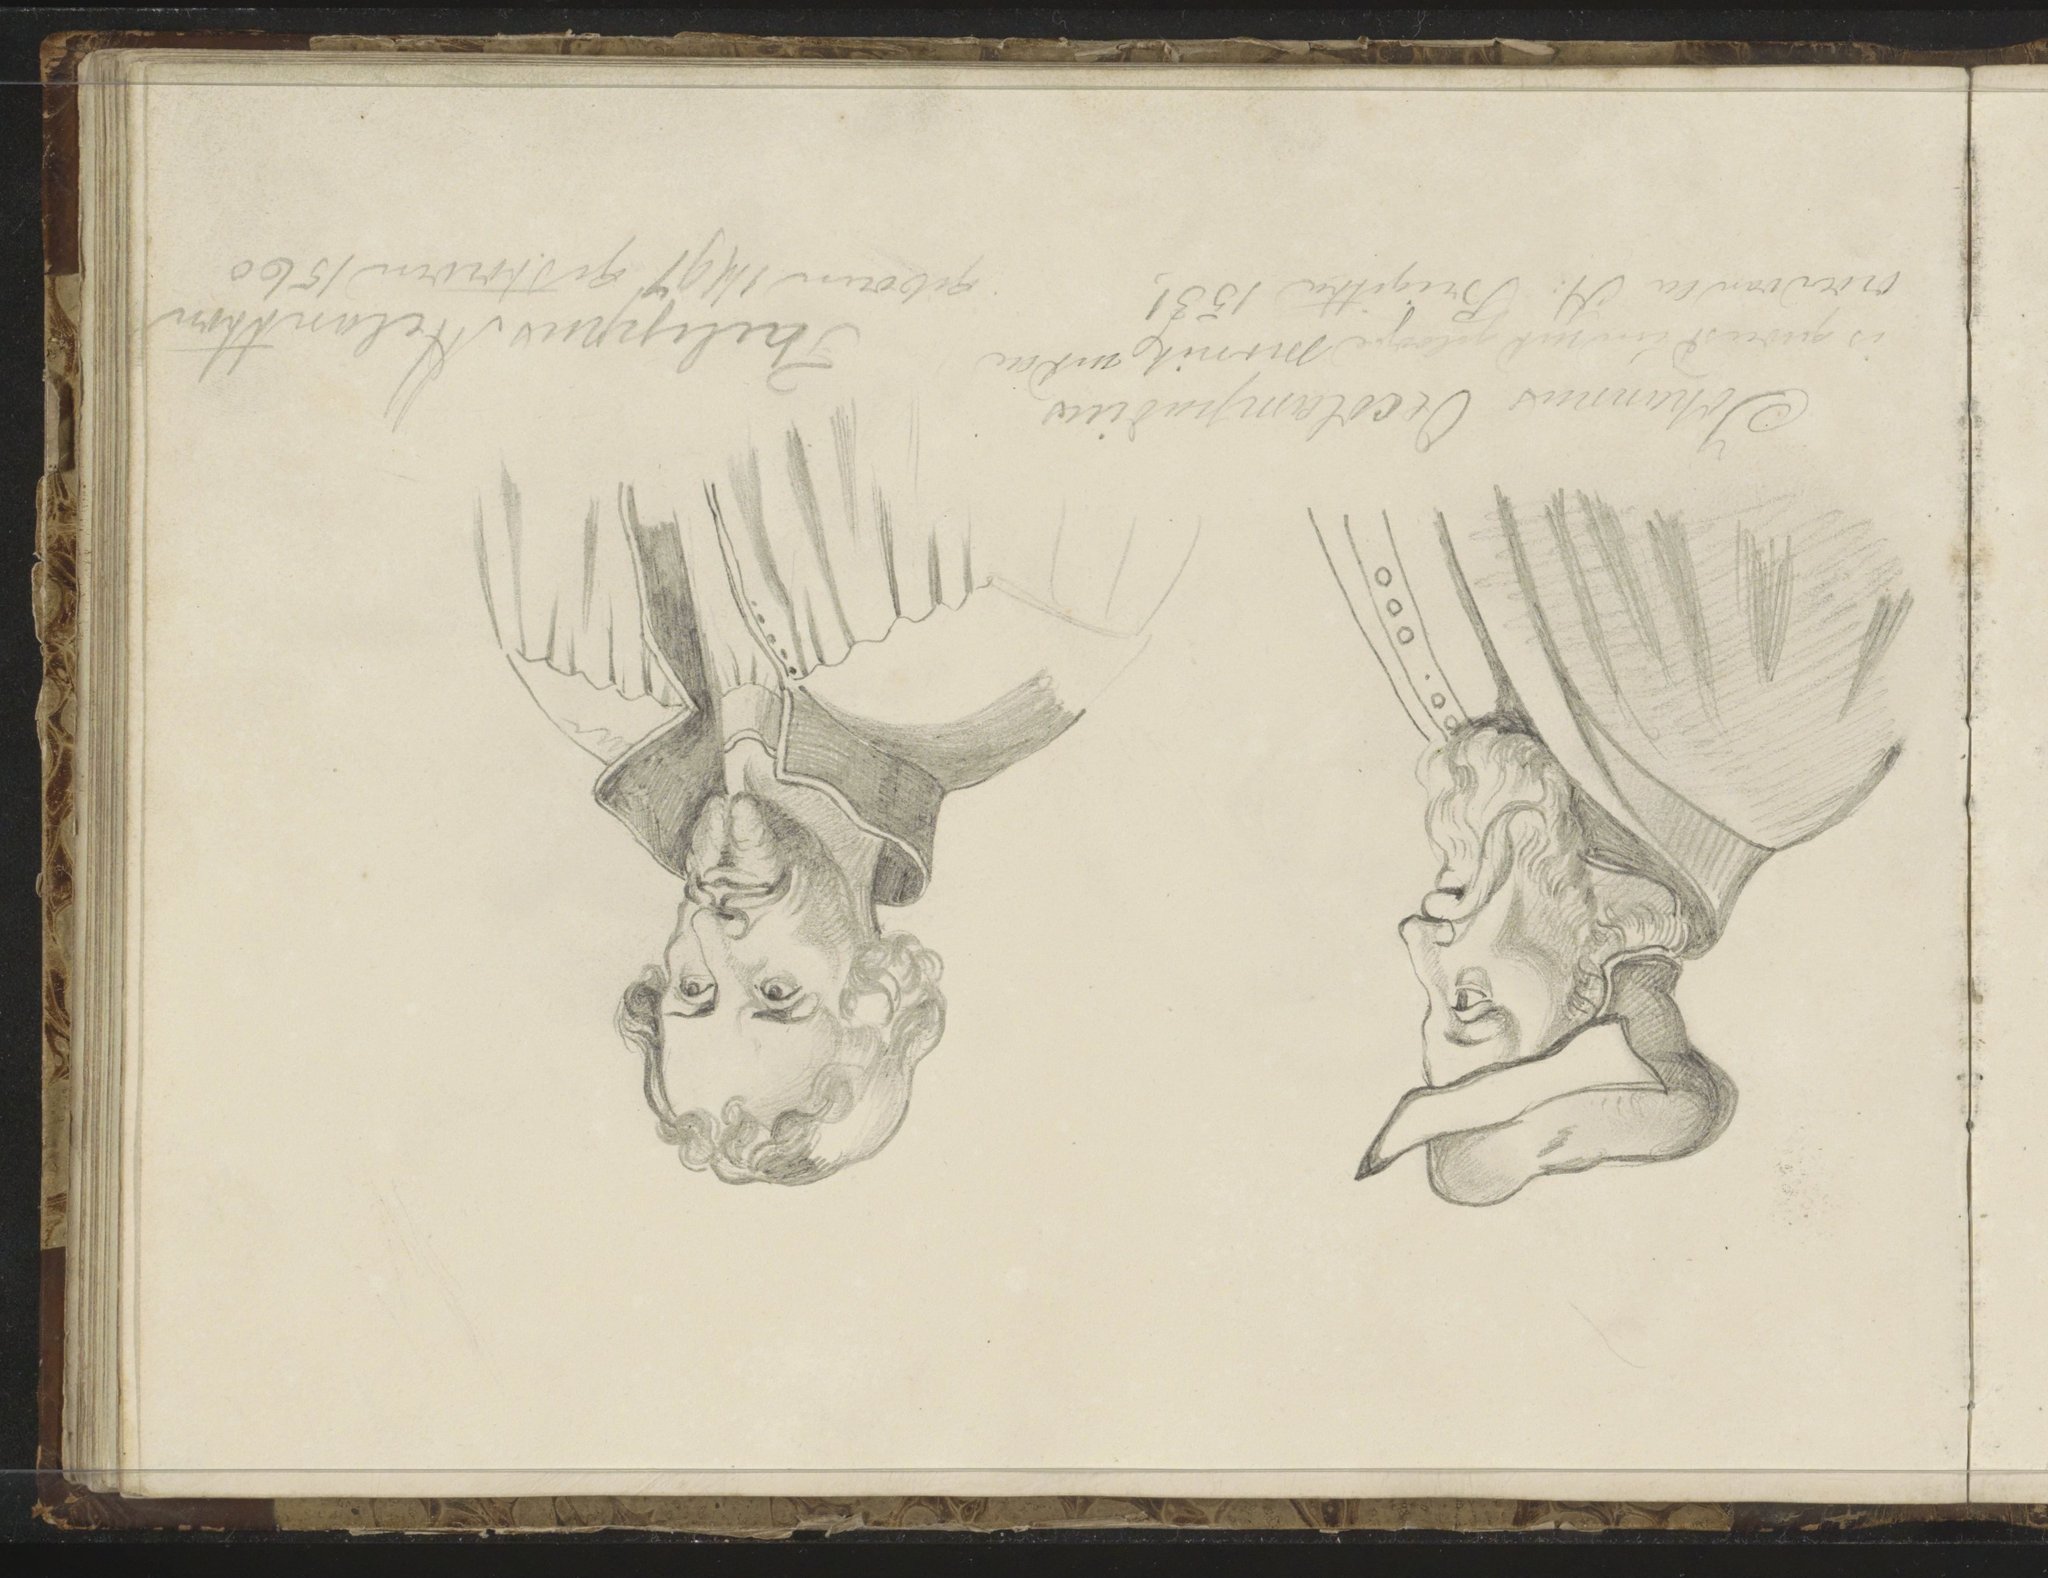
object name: sketchbook leaf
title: Portretten van Johannes Oecolampadius en Philipp Melanchthon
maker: willem hendrik schmidt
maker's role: draughtsman, painter, print maker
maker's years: 1809-1849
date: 1819-1849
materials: paper, pencil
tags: historical persons (portraits and scenes from the life)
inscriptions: annotation: ‘Johannus Oecolampadius/ is geweest een uit geloo[...] monik uit de/ order van de H: Brigitta 1531,/ Philippus Melanthon/ geboren 1497 gestorven 1560’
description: Blad 29 verso uit een schetsboek met 52 bladen.